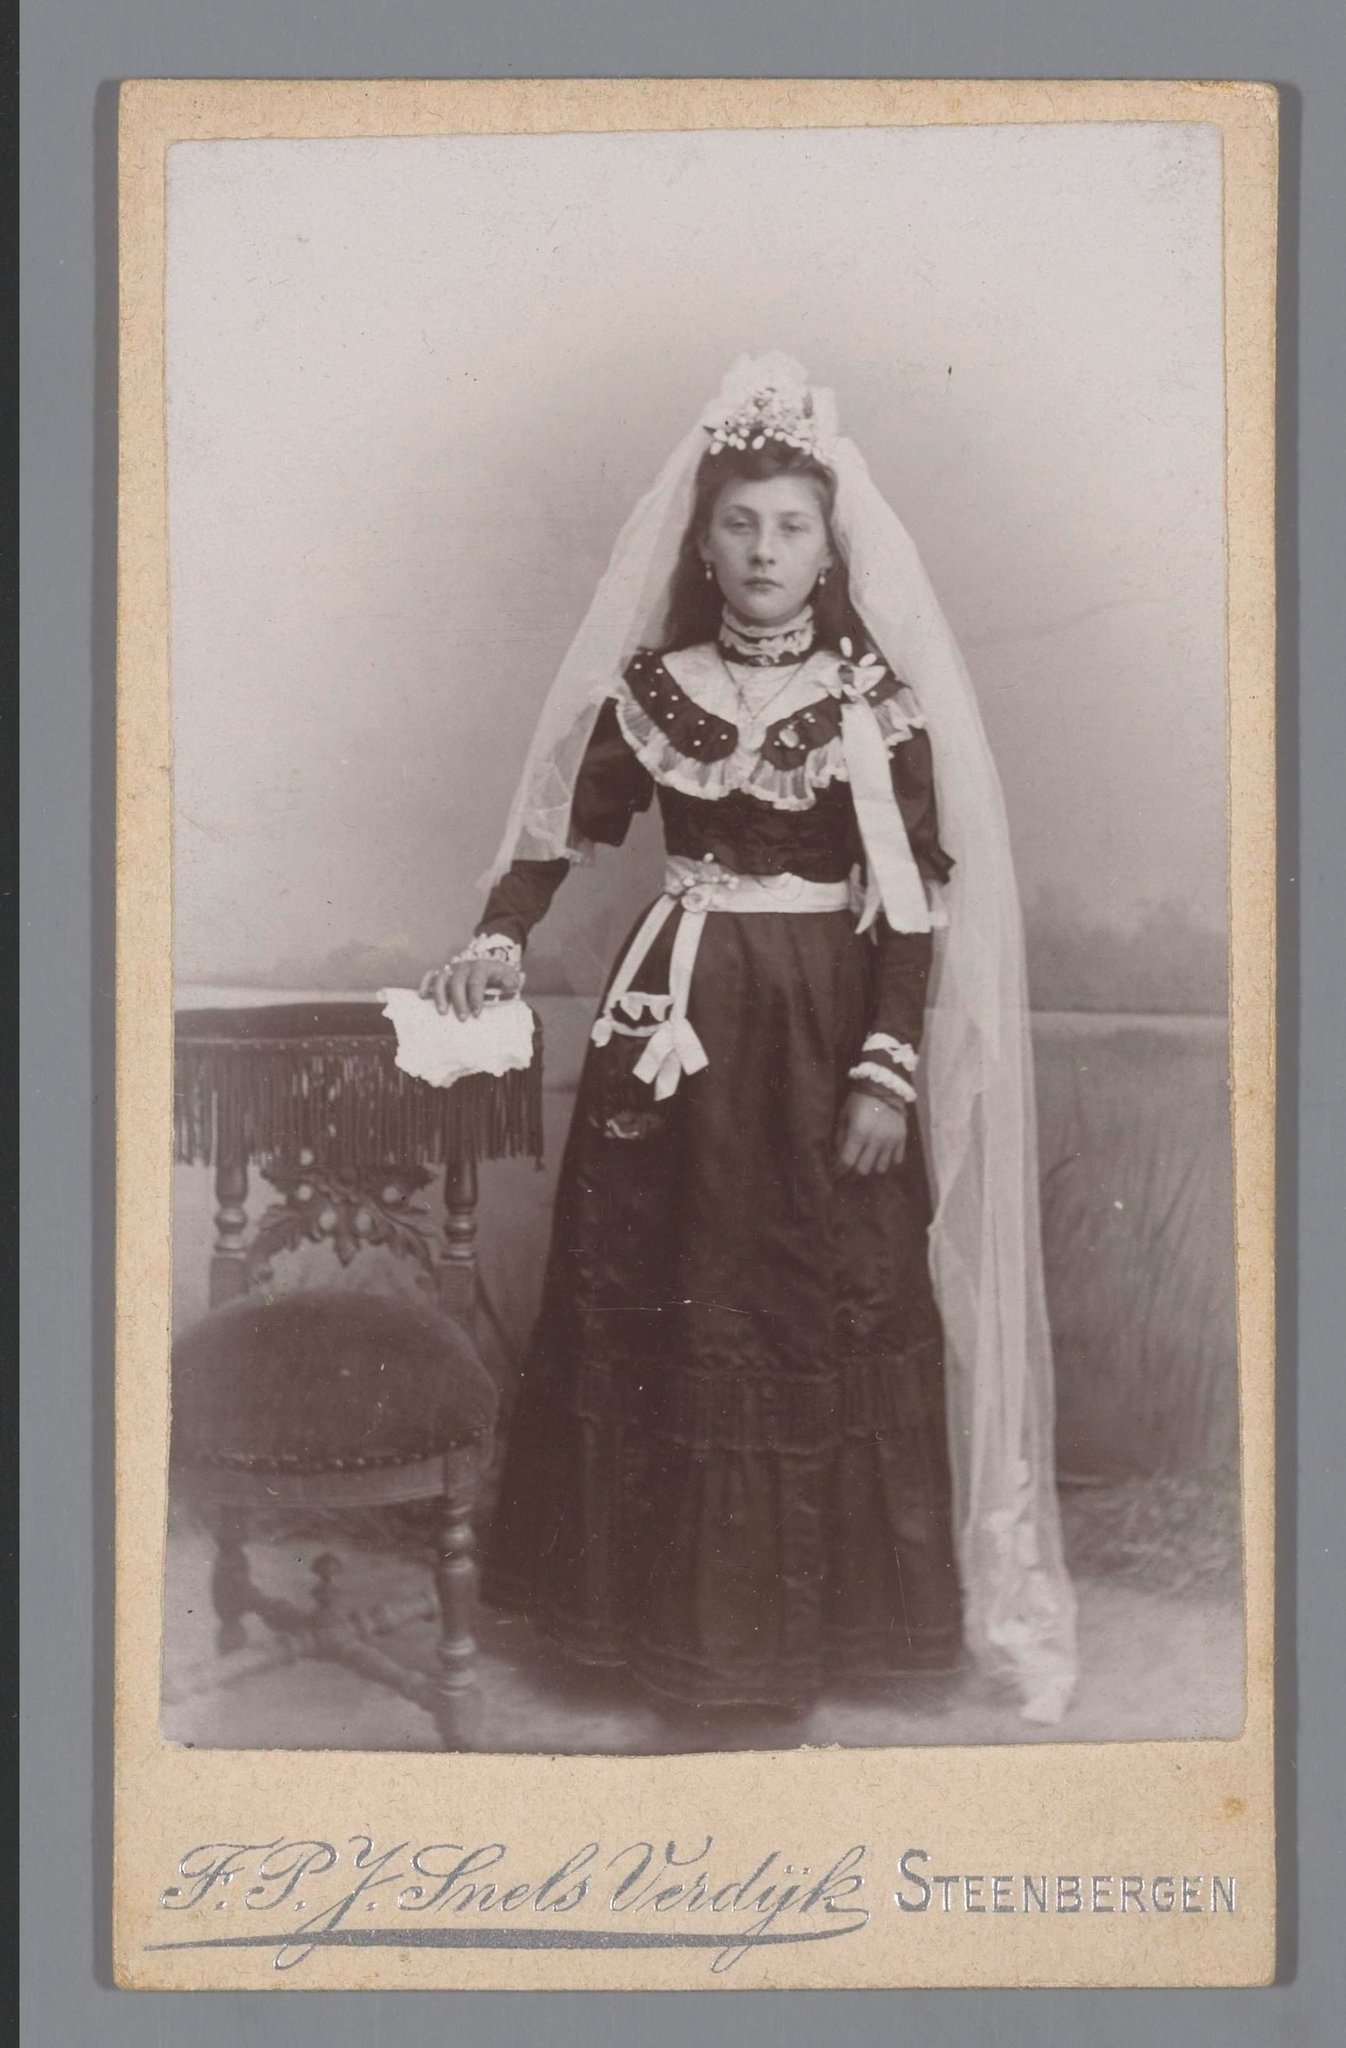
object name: carte de visite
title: Portret van een onbekend meisje in een communiejurk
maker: franciscus petrus johannes snels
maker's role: fotograaf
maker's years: 1858-1938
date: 1870-1910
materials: cardboard, photographic support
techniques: daylight paper print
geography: steenbergen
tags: first communion